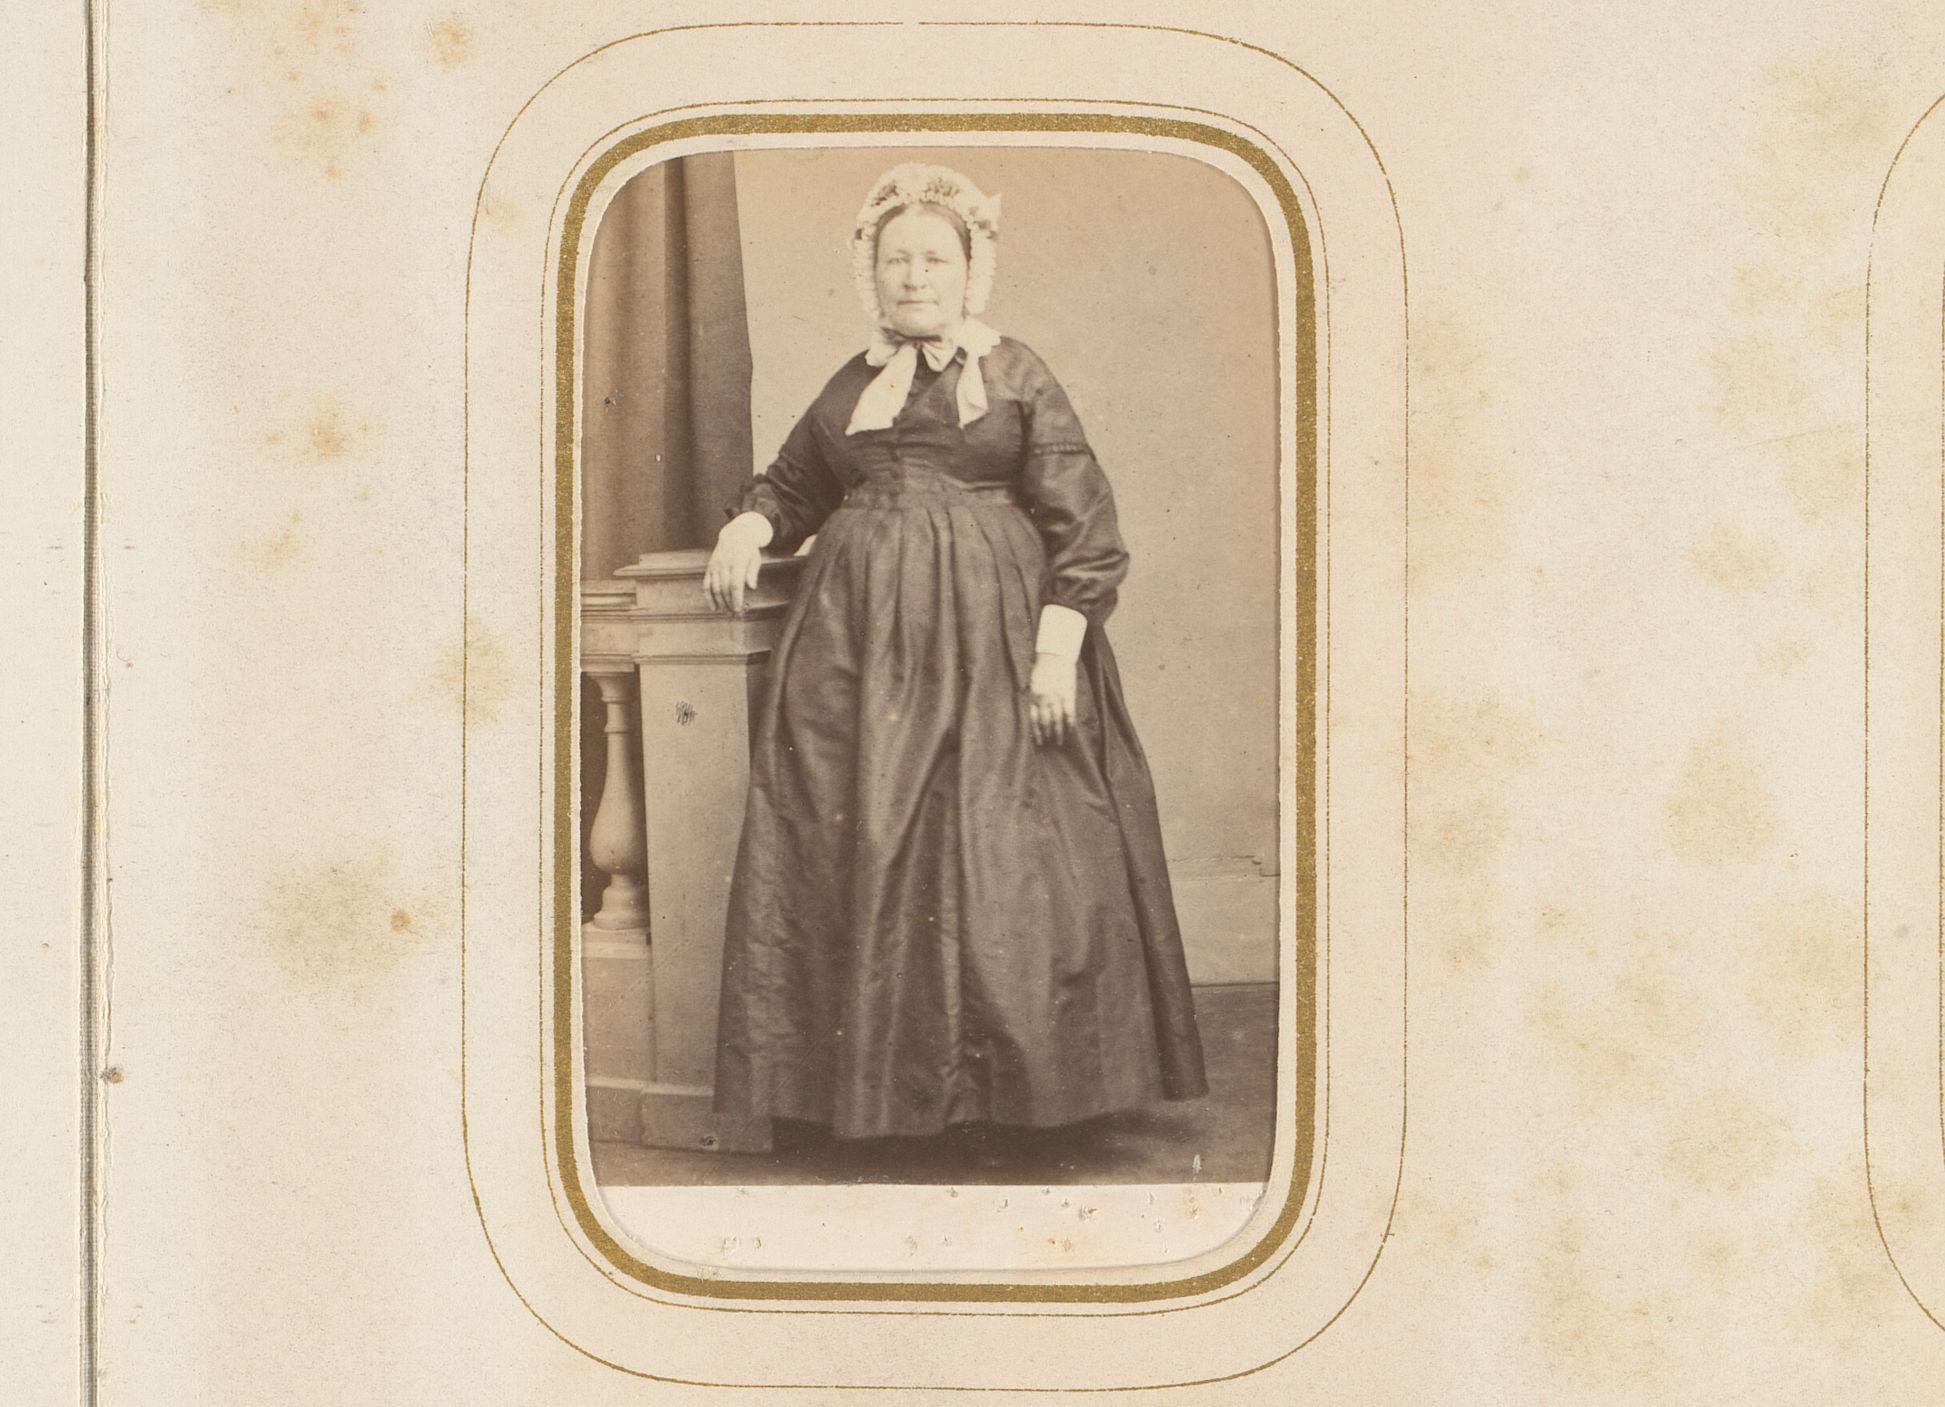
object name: carte de visite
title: Portret van een vrouw met muts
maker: Anonymous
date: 1860-1890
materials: cardboard, photographic support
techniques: albumen print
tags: historical persons - bb - woman, head-gear: hat